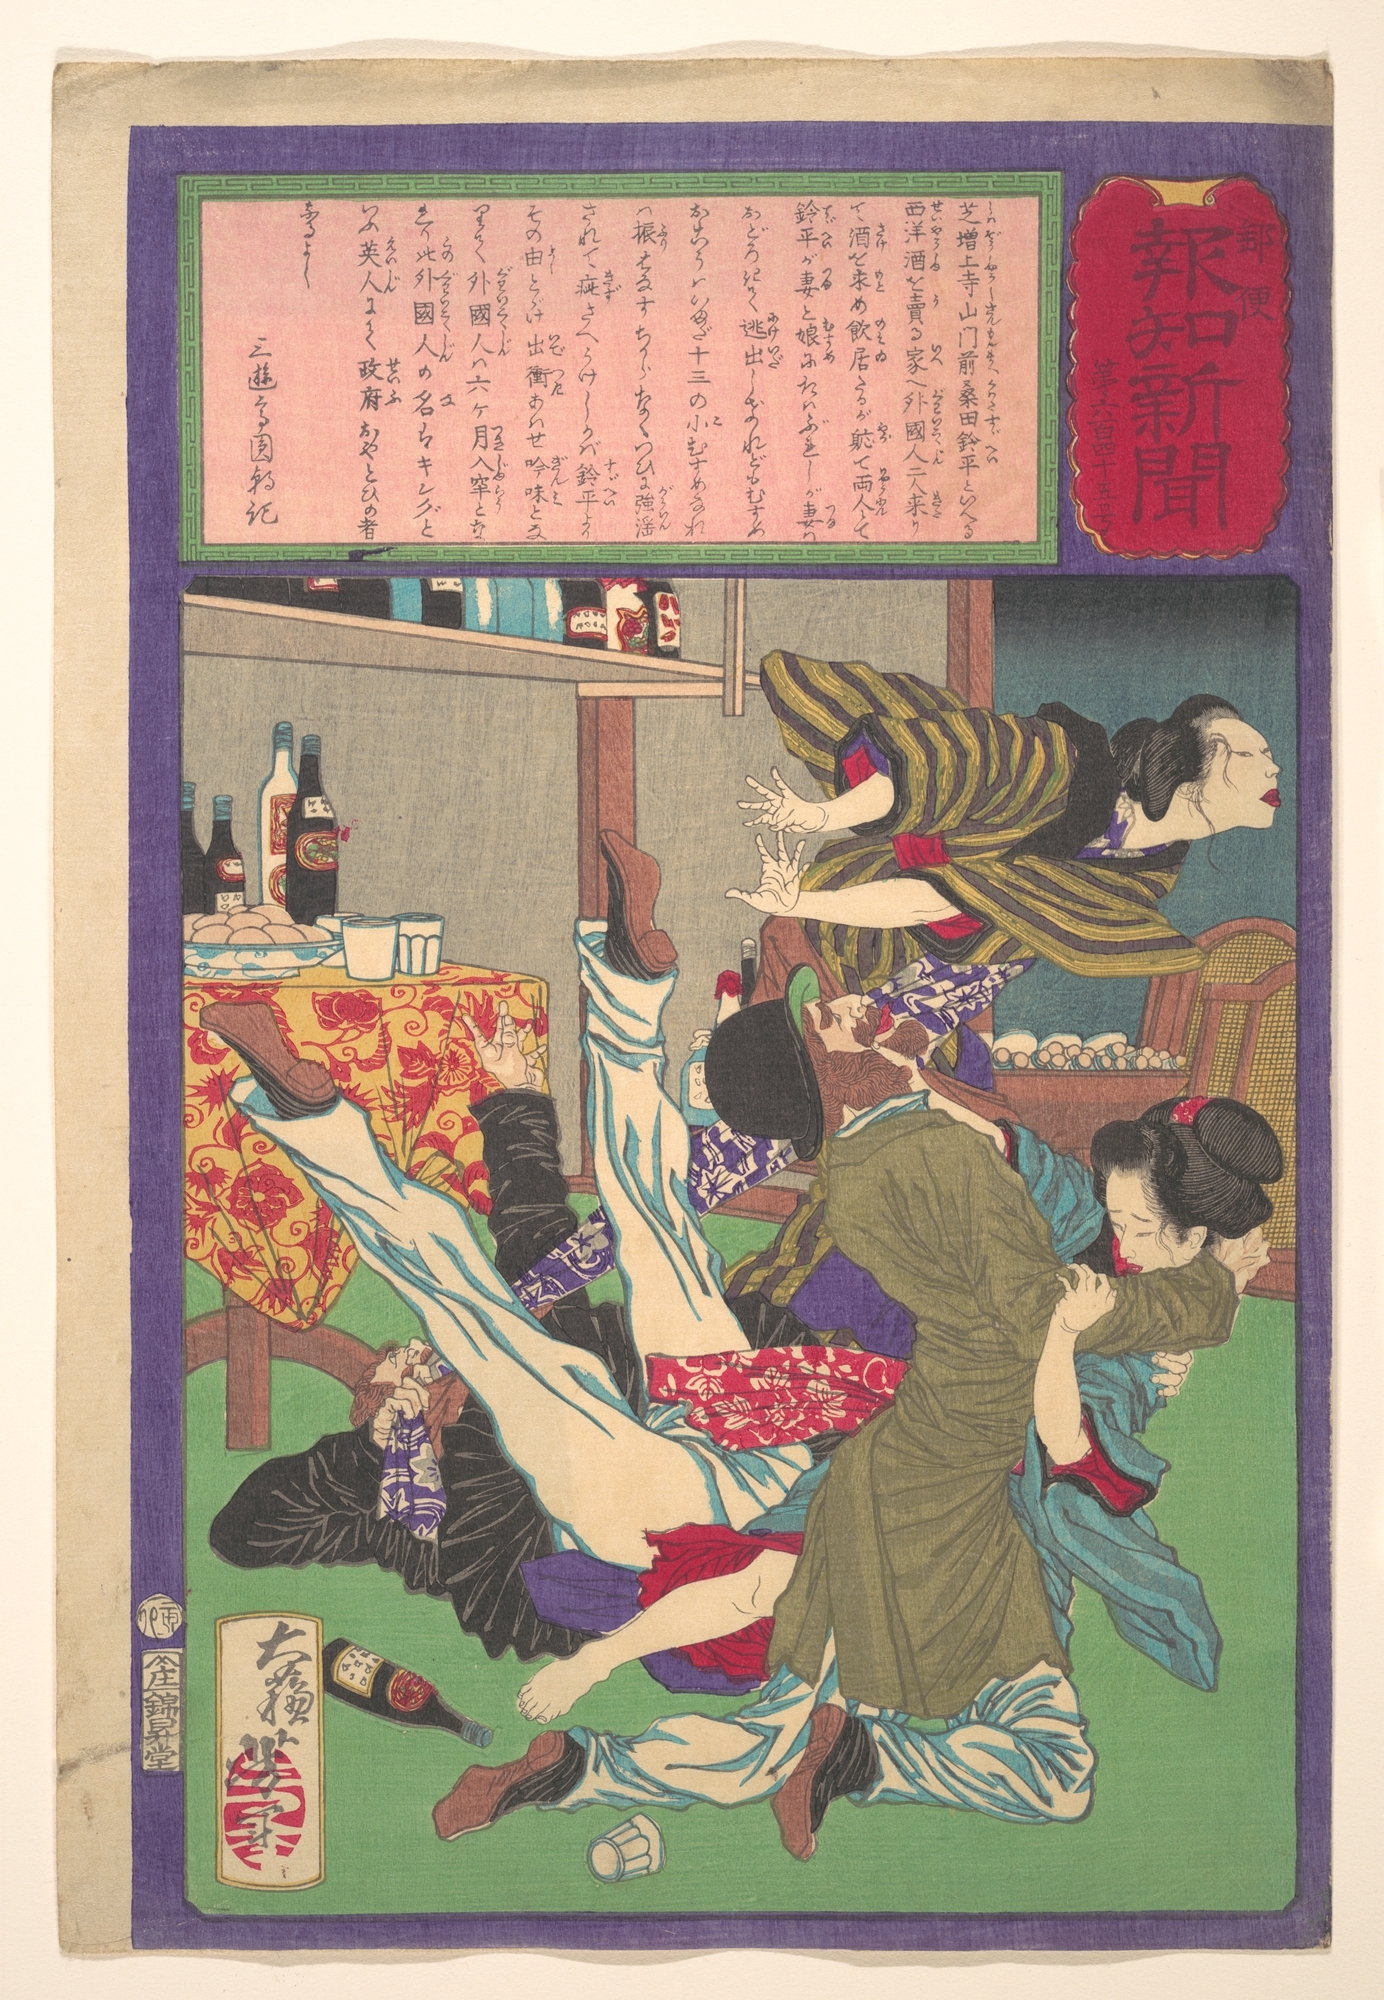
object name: print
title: Postal Hōchi Newspaper no. 645, Englishman raping a wine shopkeeper's daughter (Yūbin Hōchi shinbun, roppyaku yonjū gogō)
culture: japanese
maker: tsukioka yoshitoshi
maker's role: artist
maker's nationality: japanese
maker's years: 1839-1892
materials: ink, paper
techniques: woodblock print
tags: men,women,japanese